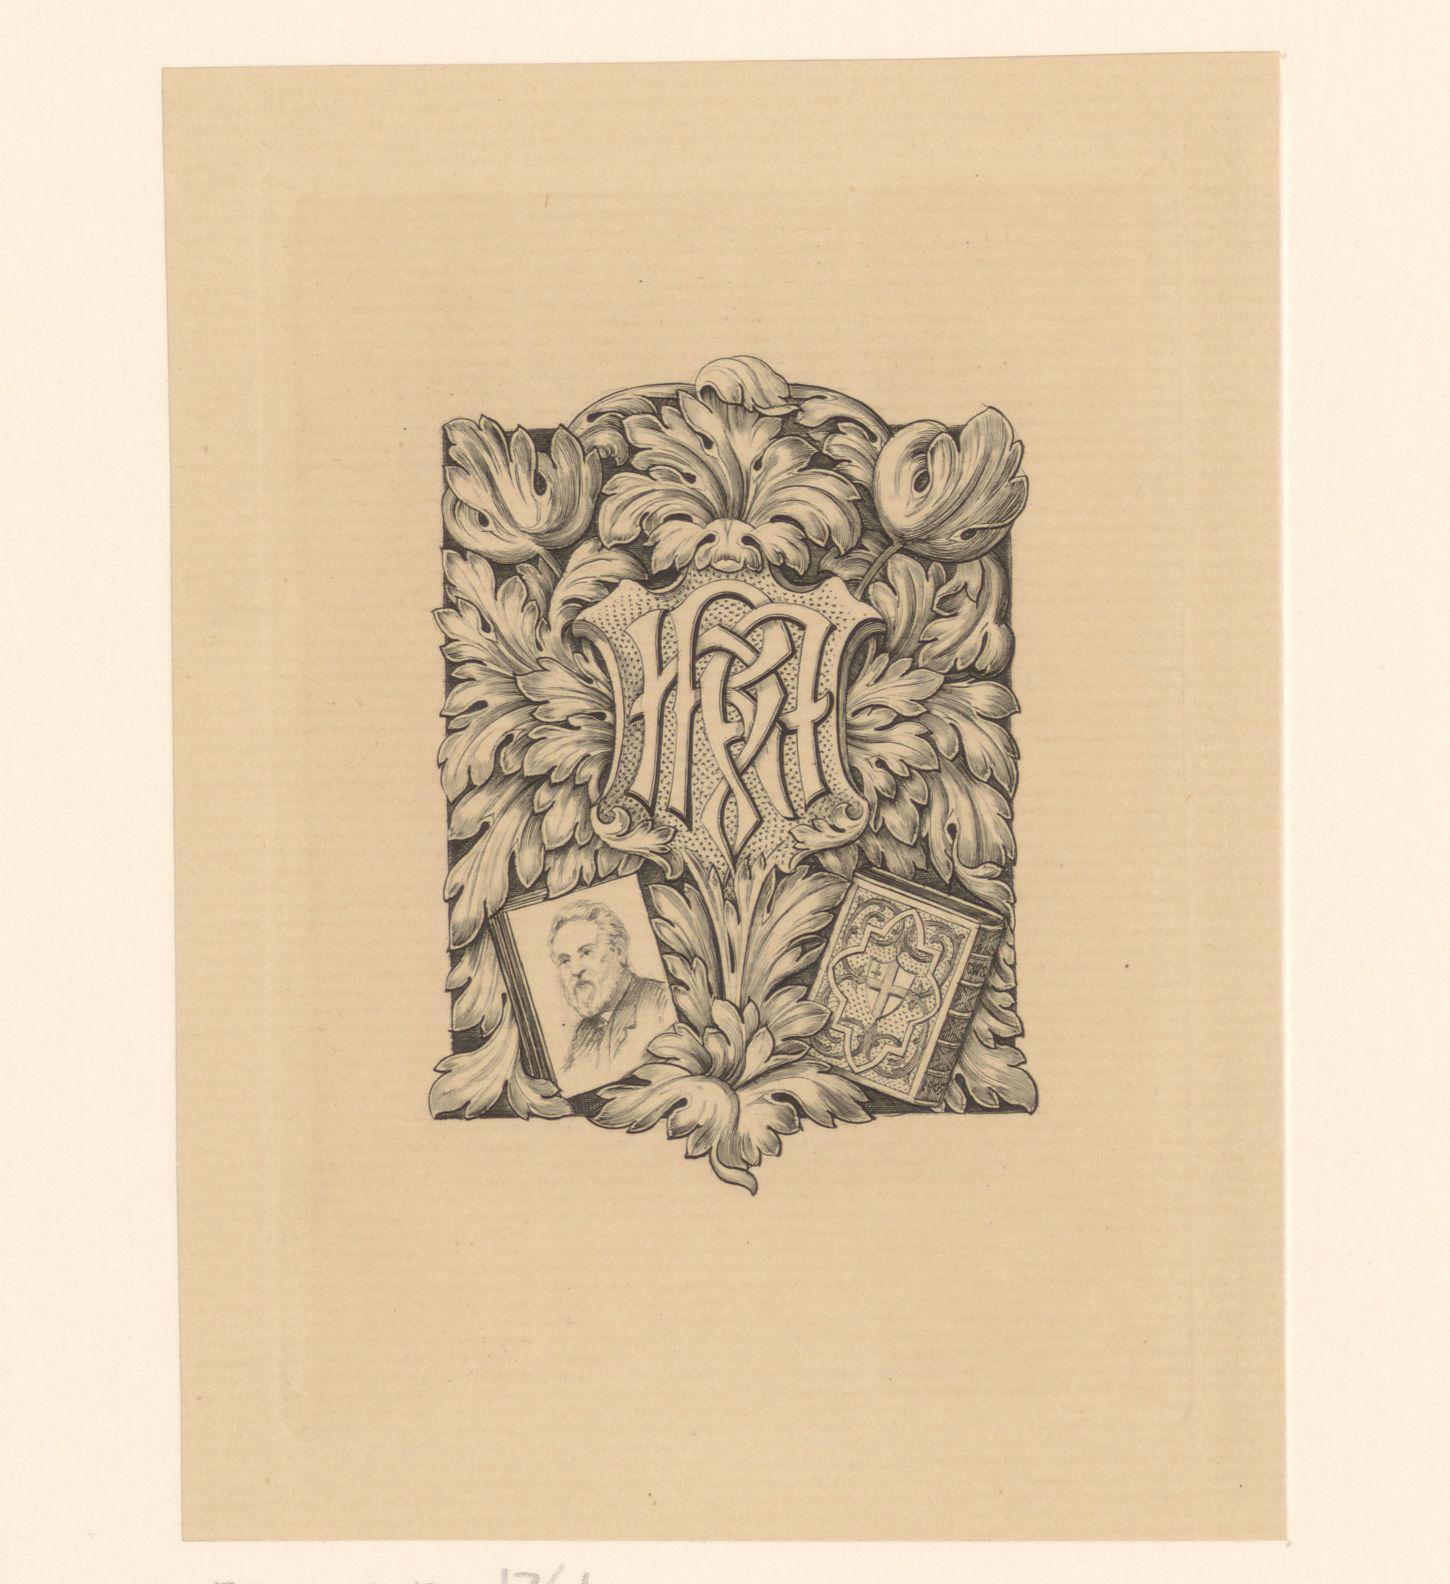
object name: bookplate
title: Ex libris van onbekend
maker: charles william sherborn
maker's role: print maker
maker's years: 1831-1912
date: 1903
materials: paper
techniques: engraving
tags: foliage ~ ornament, historical persons, book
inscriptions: collector's mark: Lugt 2228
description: Portret naast het boek. Monogram centraal.